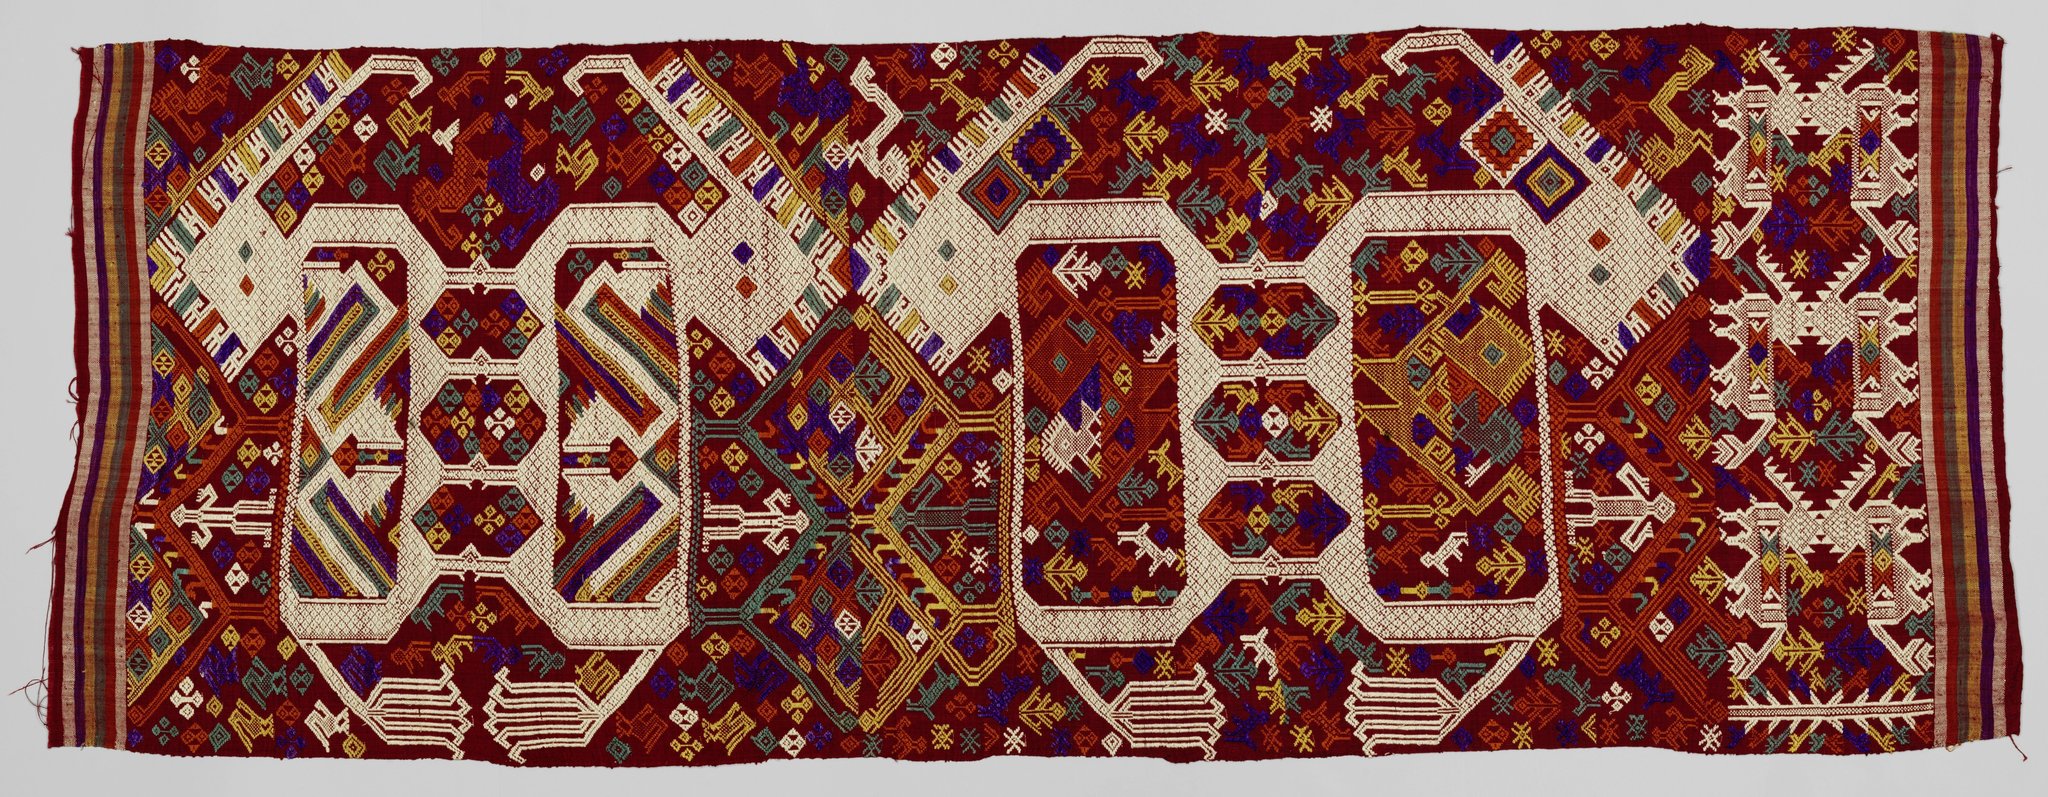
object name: cloth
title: Doek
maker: Anonymous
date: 1900-1949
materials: cotton, silk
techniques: weave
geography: laos